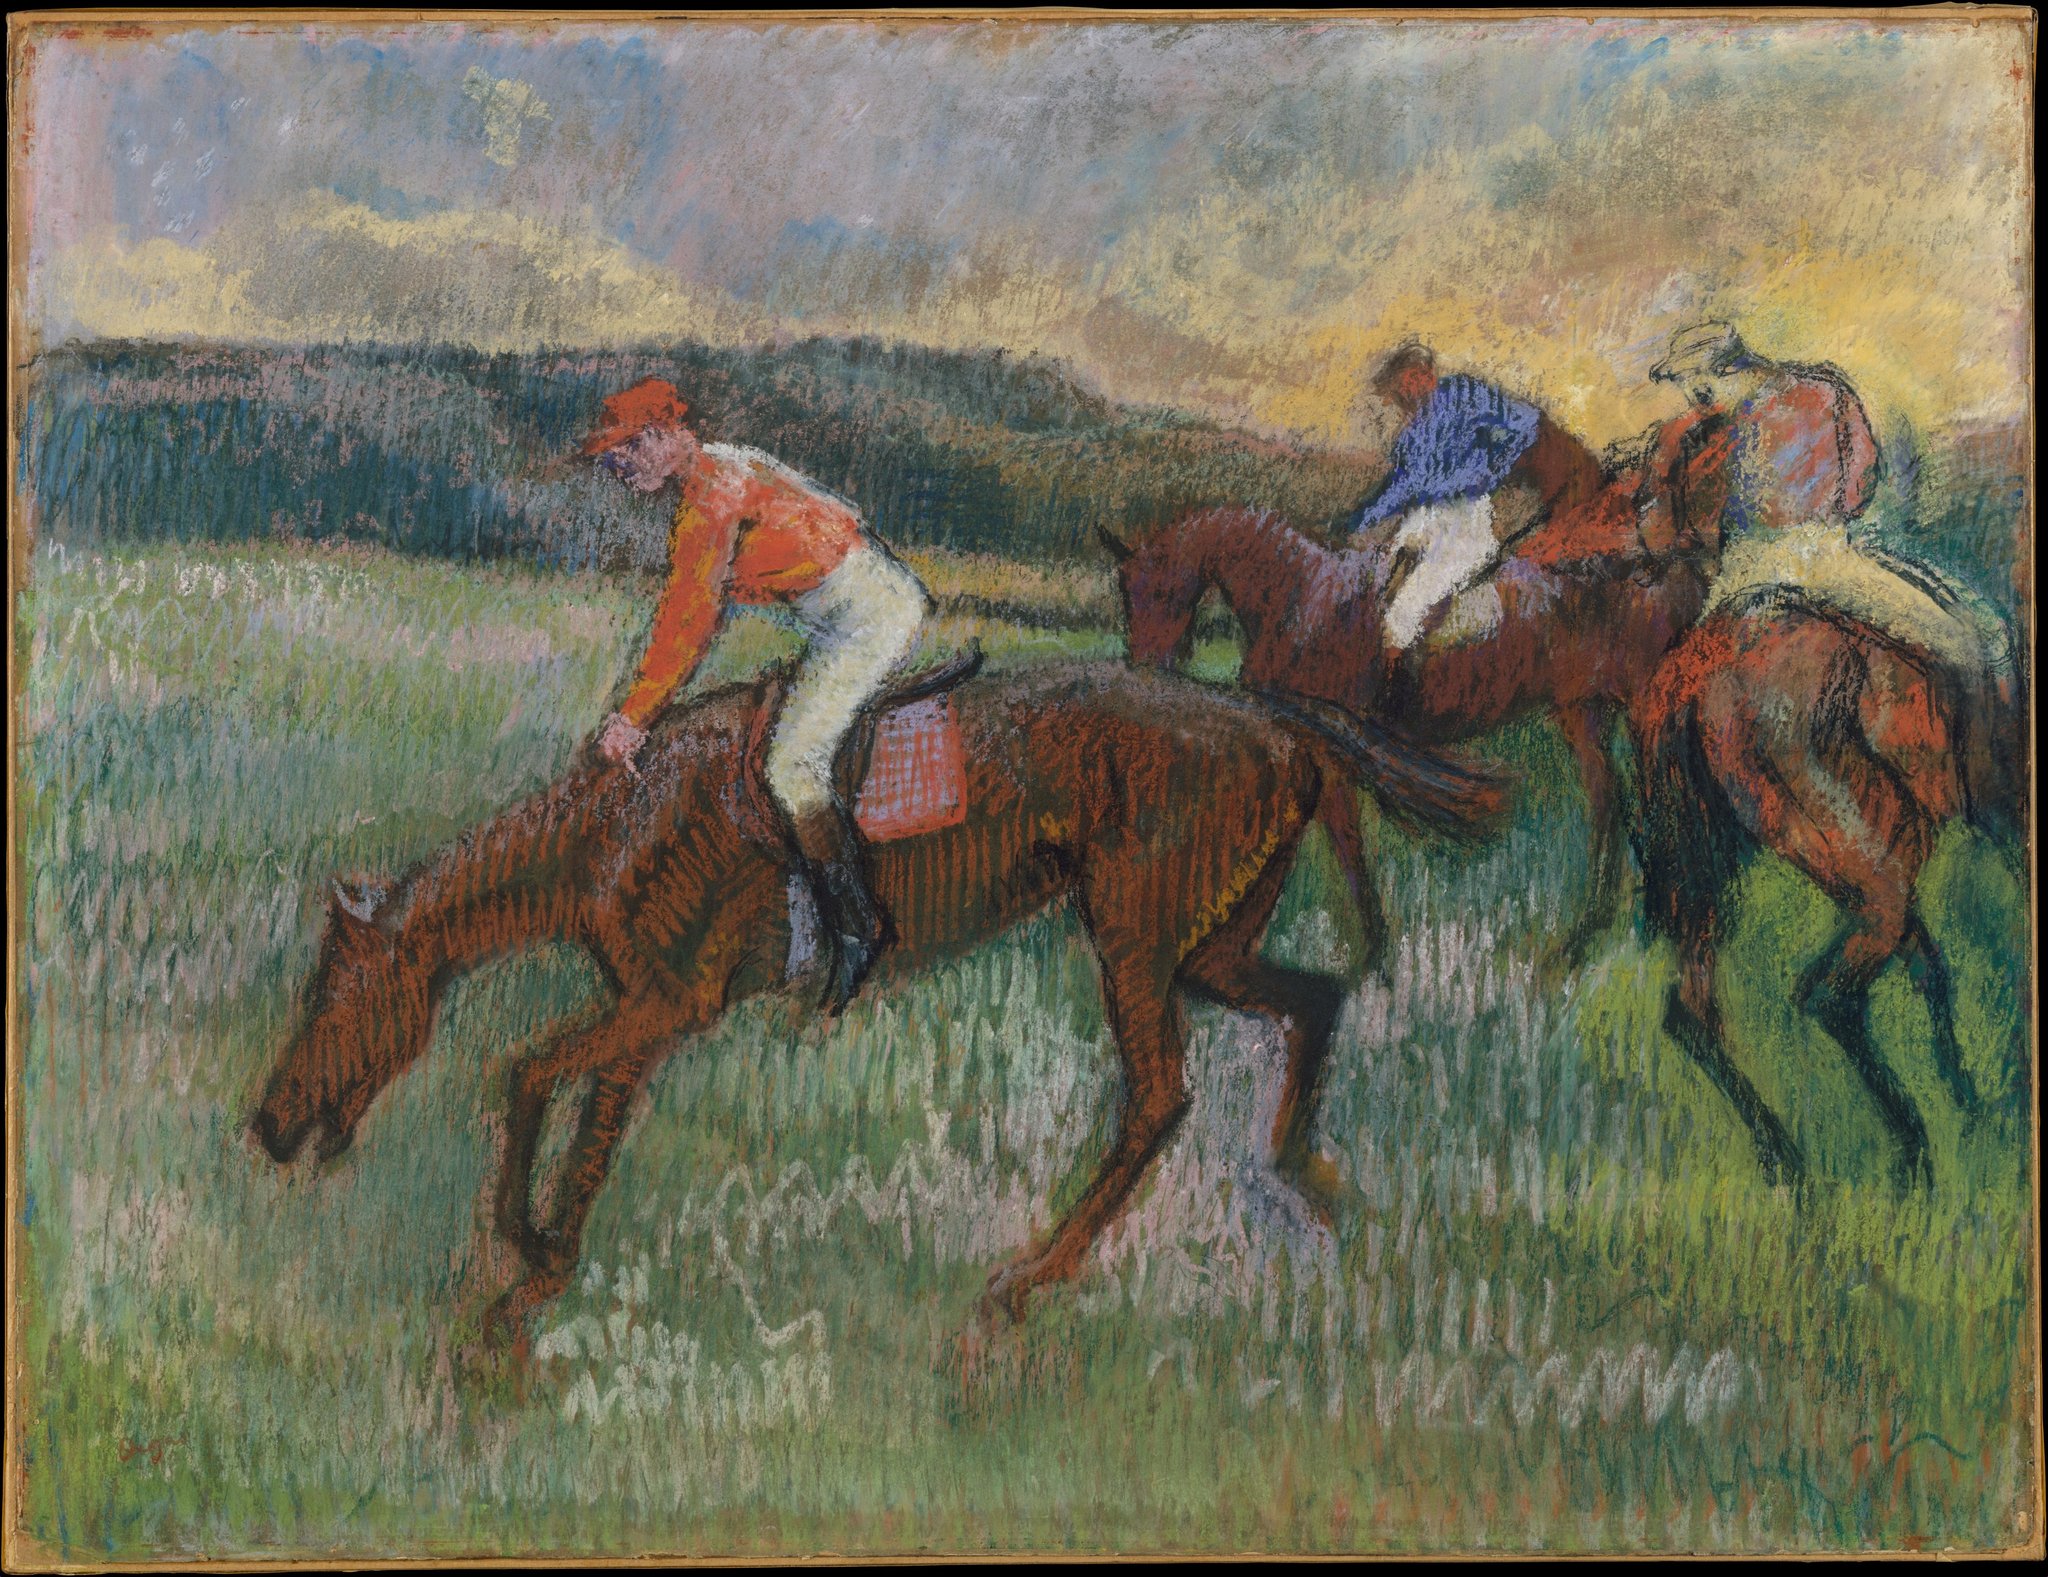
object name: drawing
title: Three Jockeys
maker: edgar degas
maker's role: artist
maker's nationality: french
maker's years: 1834-1917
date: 1900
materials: board, pastel, paper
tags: men,horses,jockeys